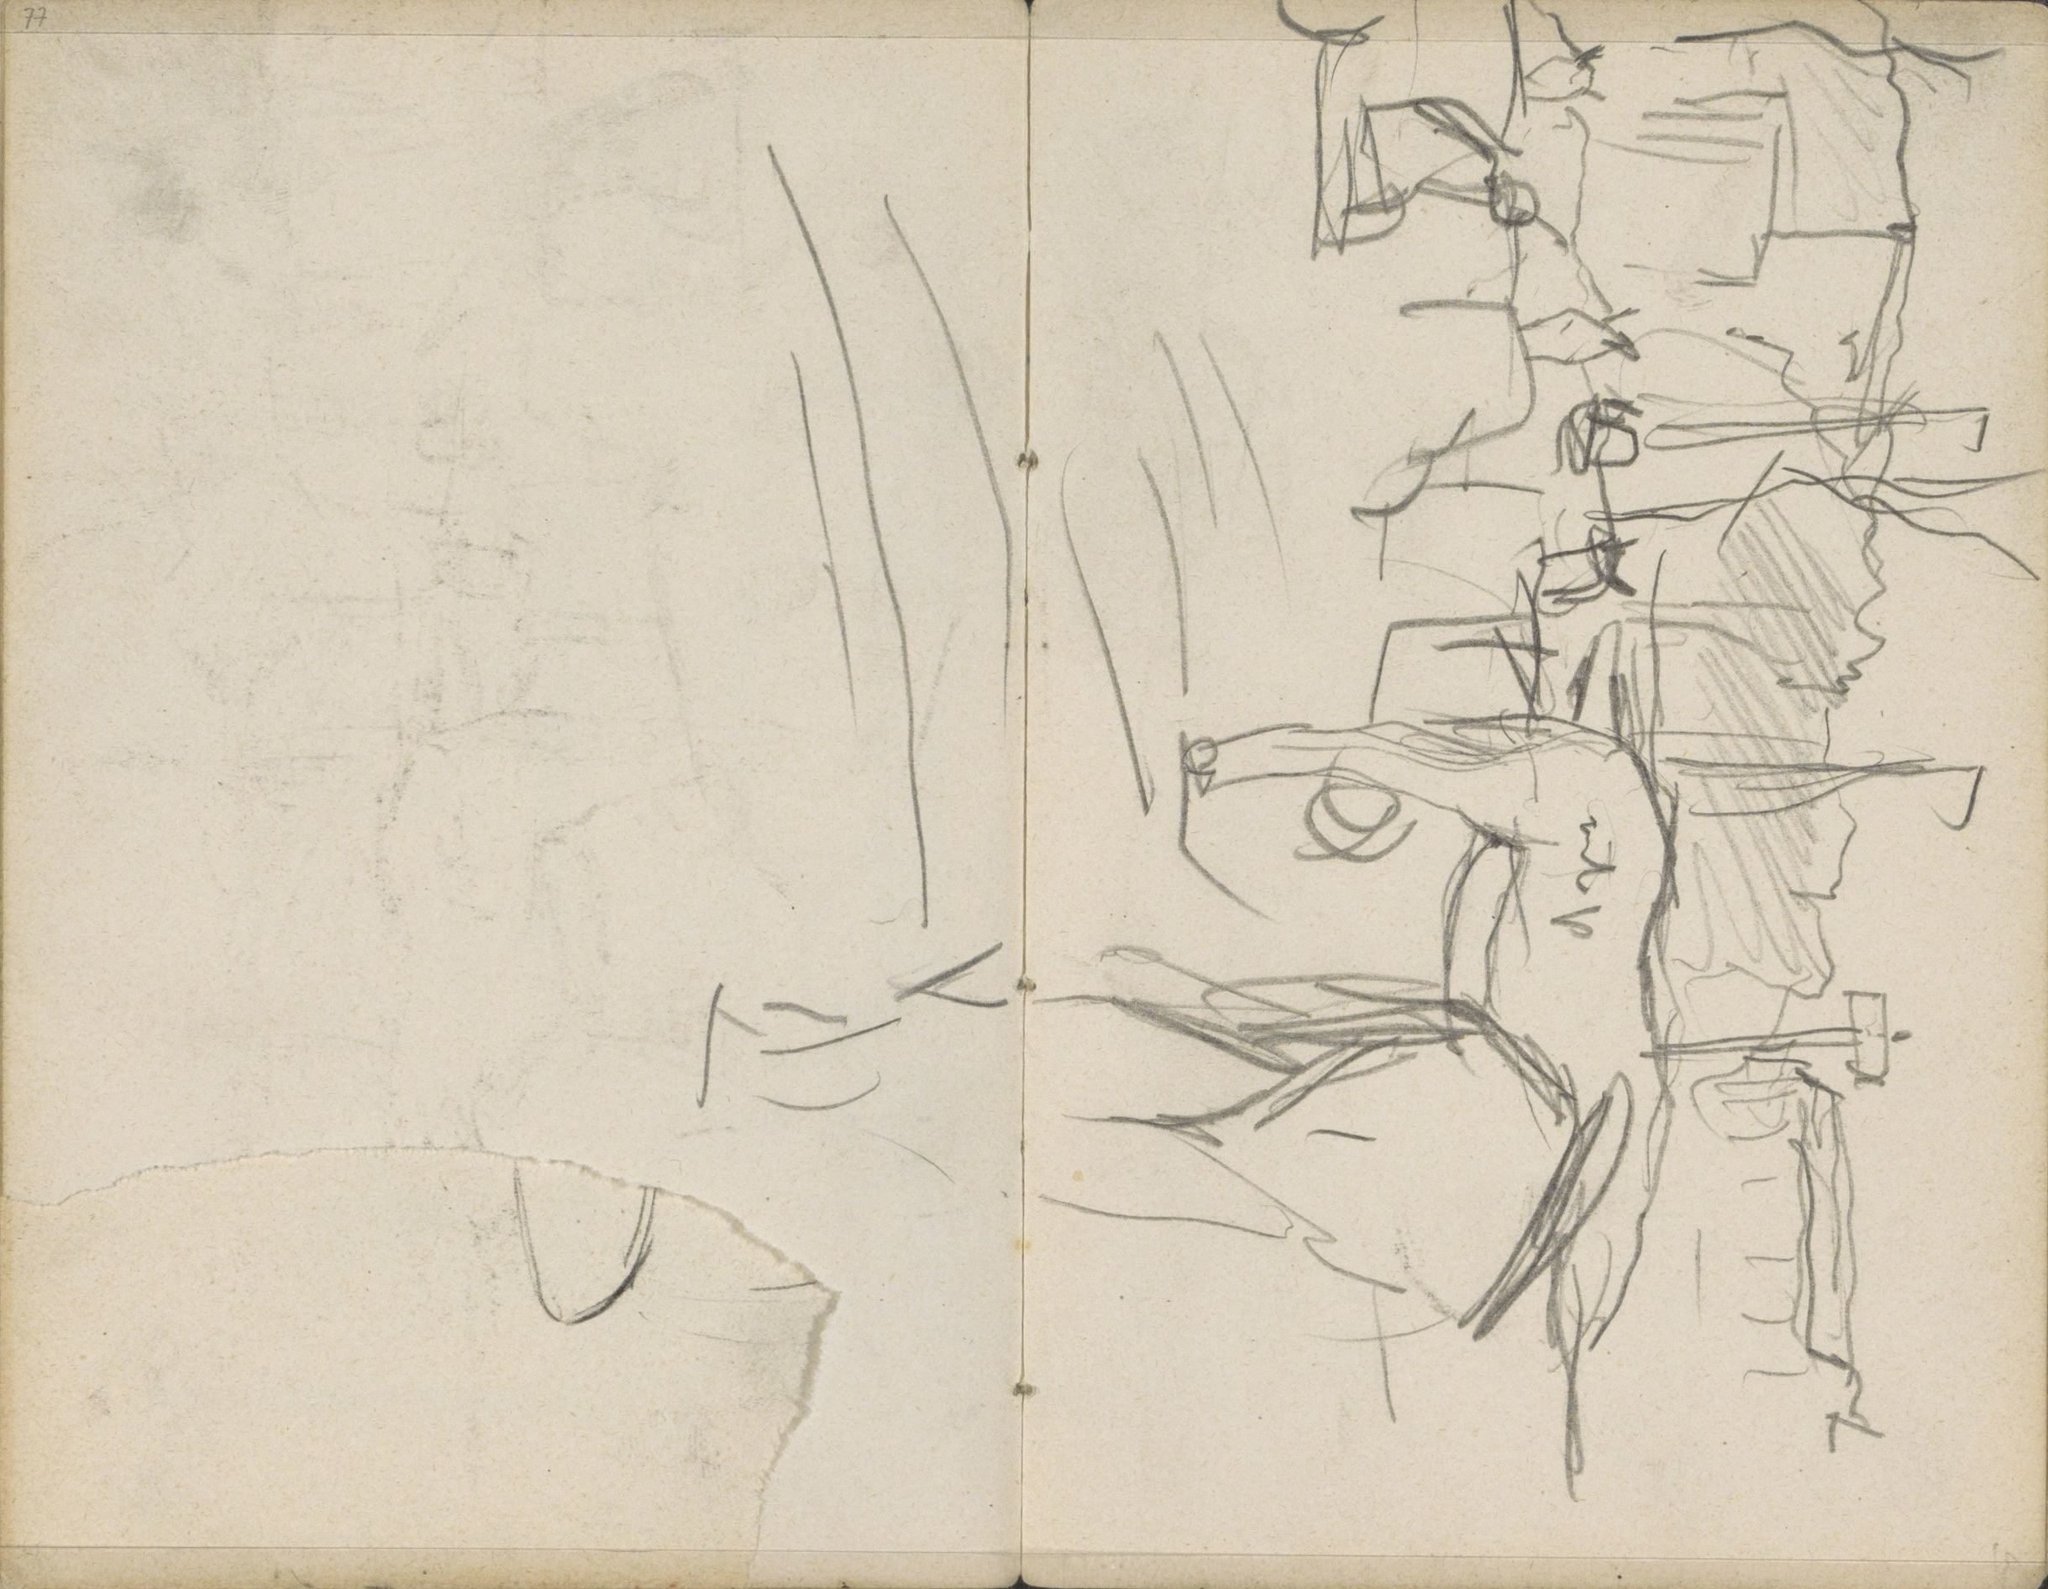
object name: sketchbook leaf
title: Gezicht in Amsterdam met boten en paarden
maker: george hendrik breitner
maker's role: draughtsman, painter, print maker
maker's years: 1857-1923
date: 1903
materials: paper, pencil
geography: amsterdam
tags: urban housing, ships (in general), canals, waters (in city), horse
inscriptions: kleurnotitie, handgeschreven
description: Gezicht in Amsterdam met boten en paarden. Pagina 77 en pagina 78 uit een schetsboek met 46 bladen.